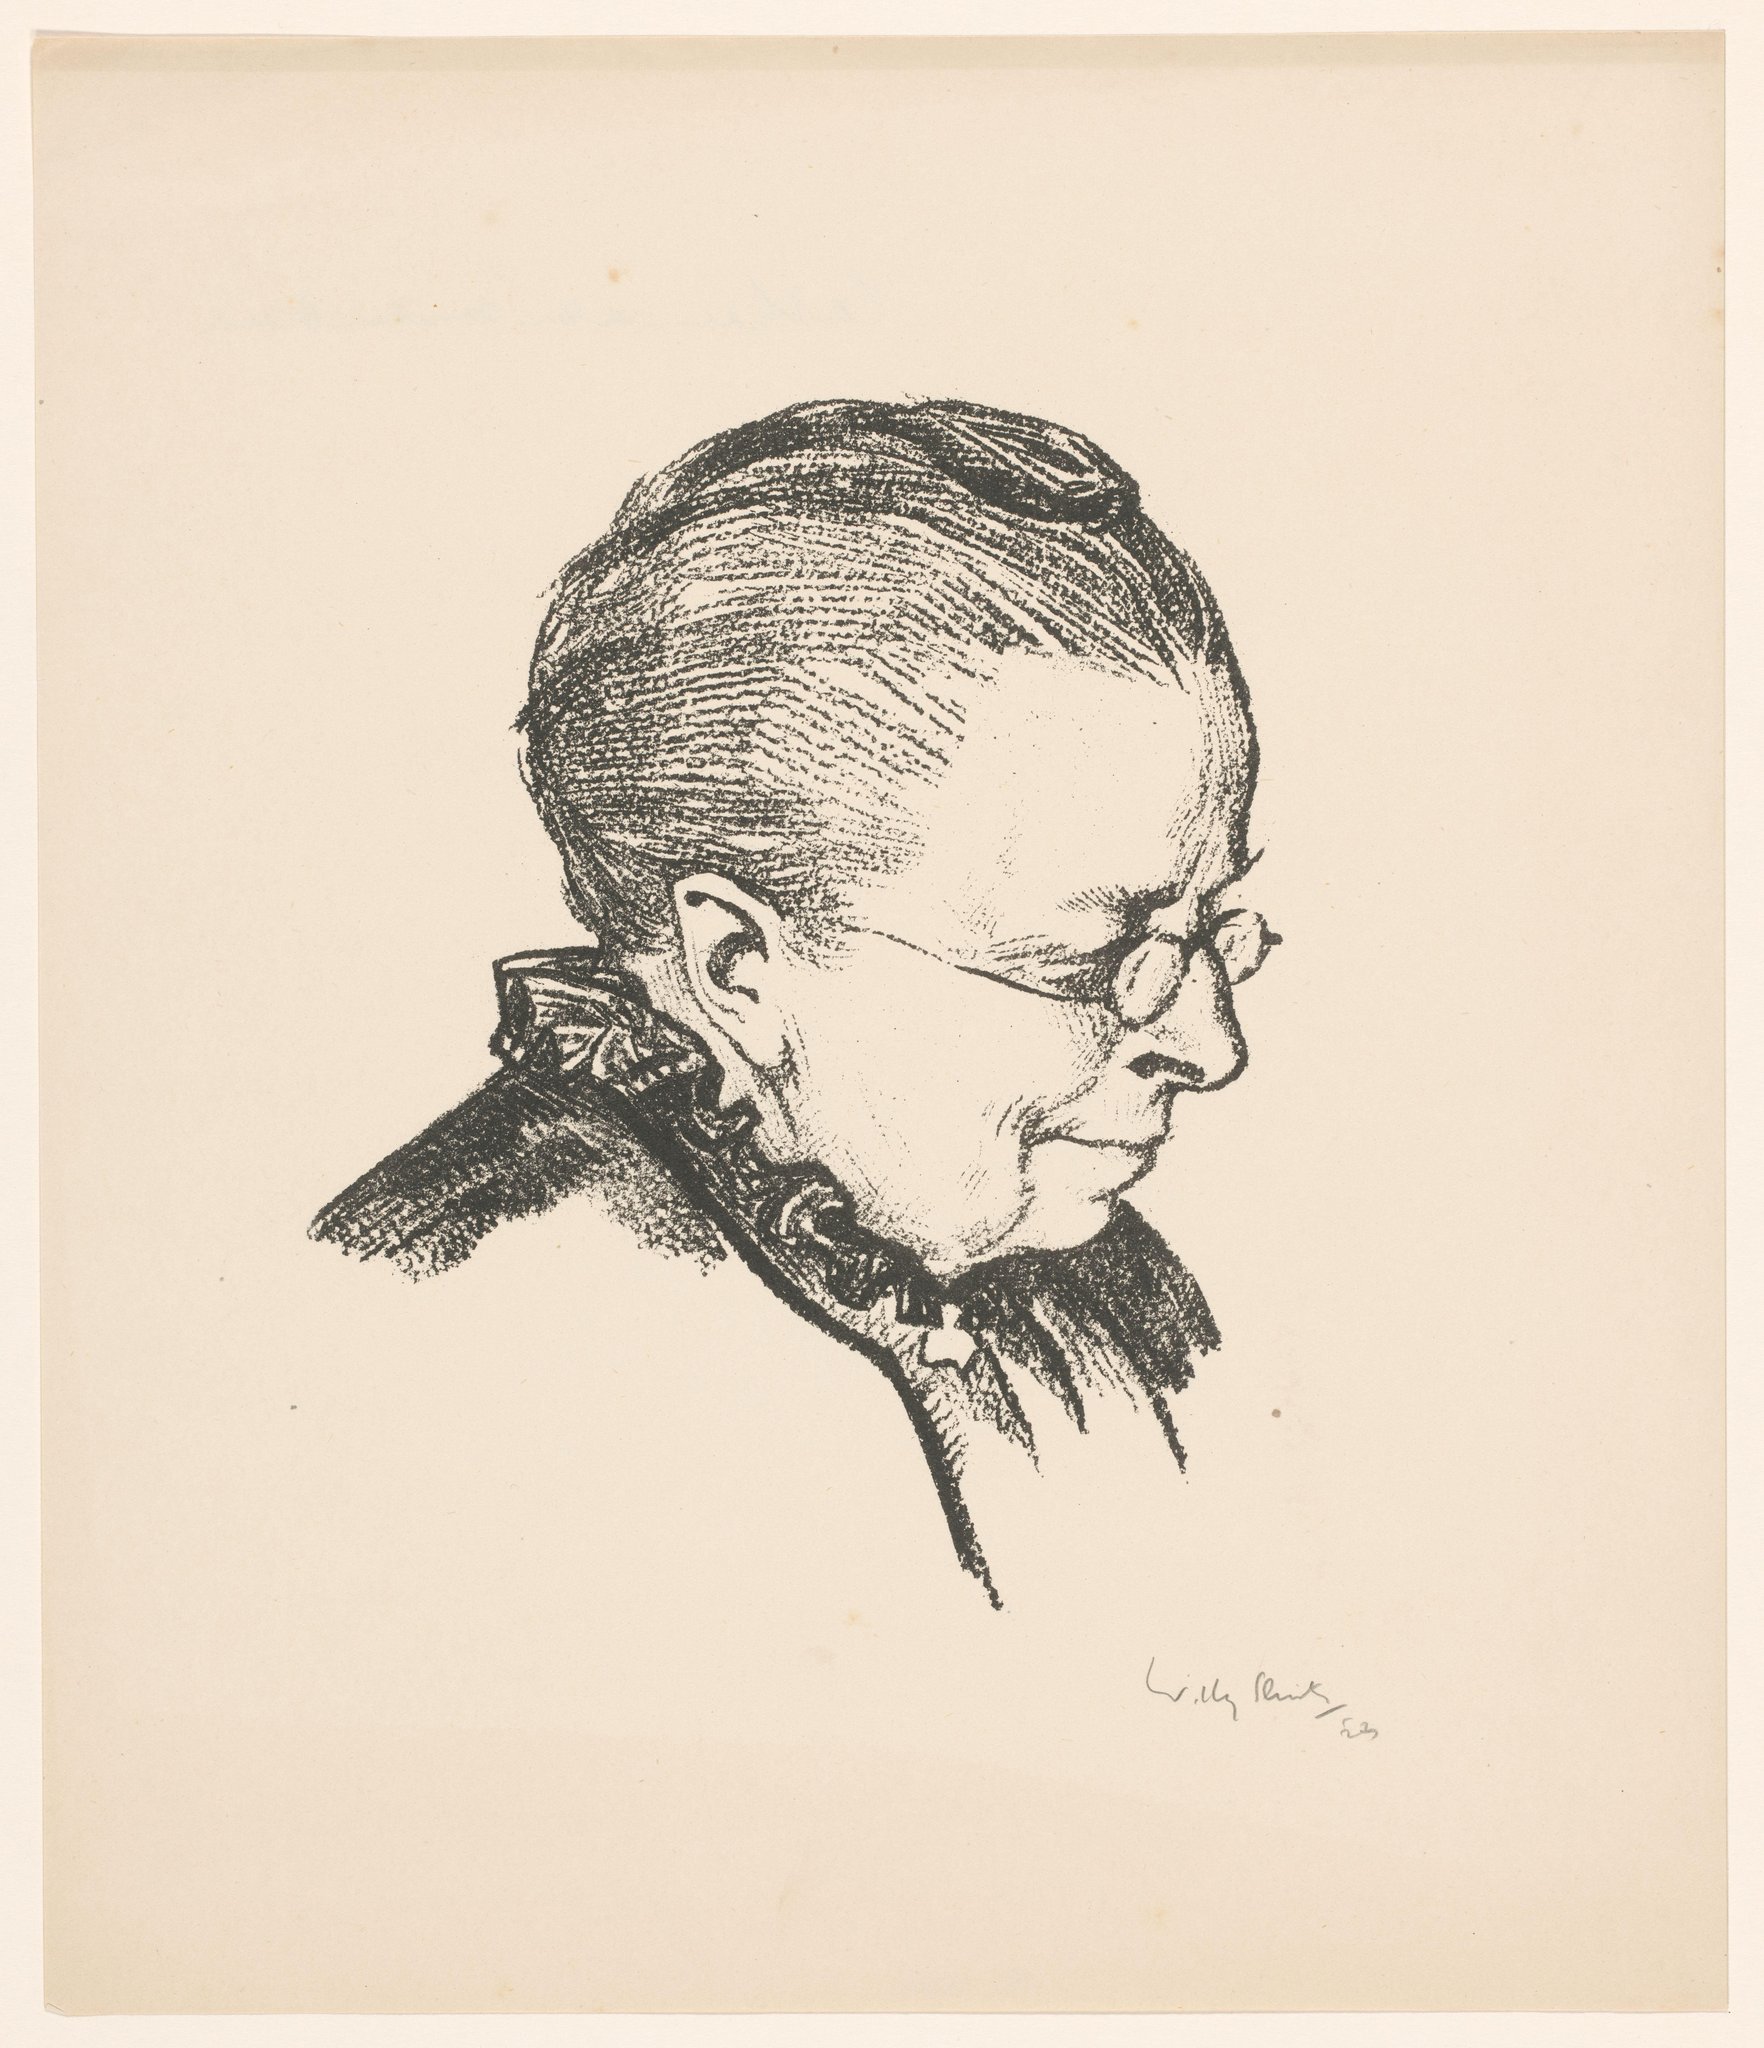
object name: print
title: Portret van Catharine van Tussenbroek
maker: willy sluiter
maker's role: draughtsman, painter, print maker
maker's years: 1873-1949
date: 1922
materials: paper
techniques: lithograph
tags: utrecht, amsterdam, historical persons - bb - woman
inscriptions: collector's mark: Lugt 2228